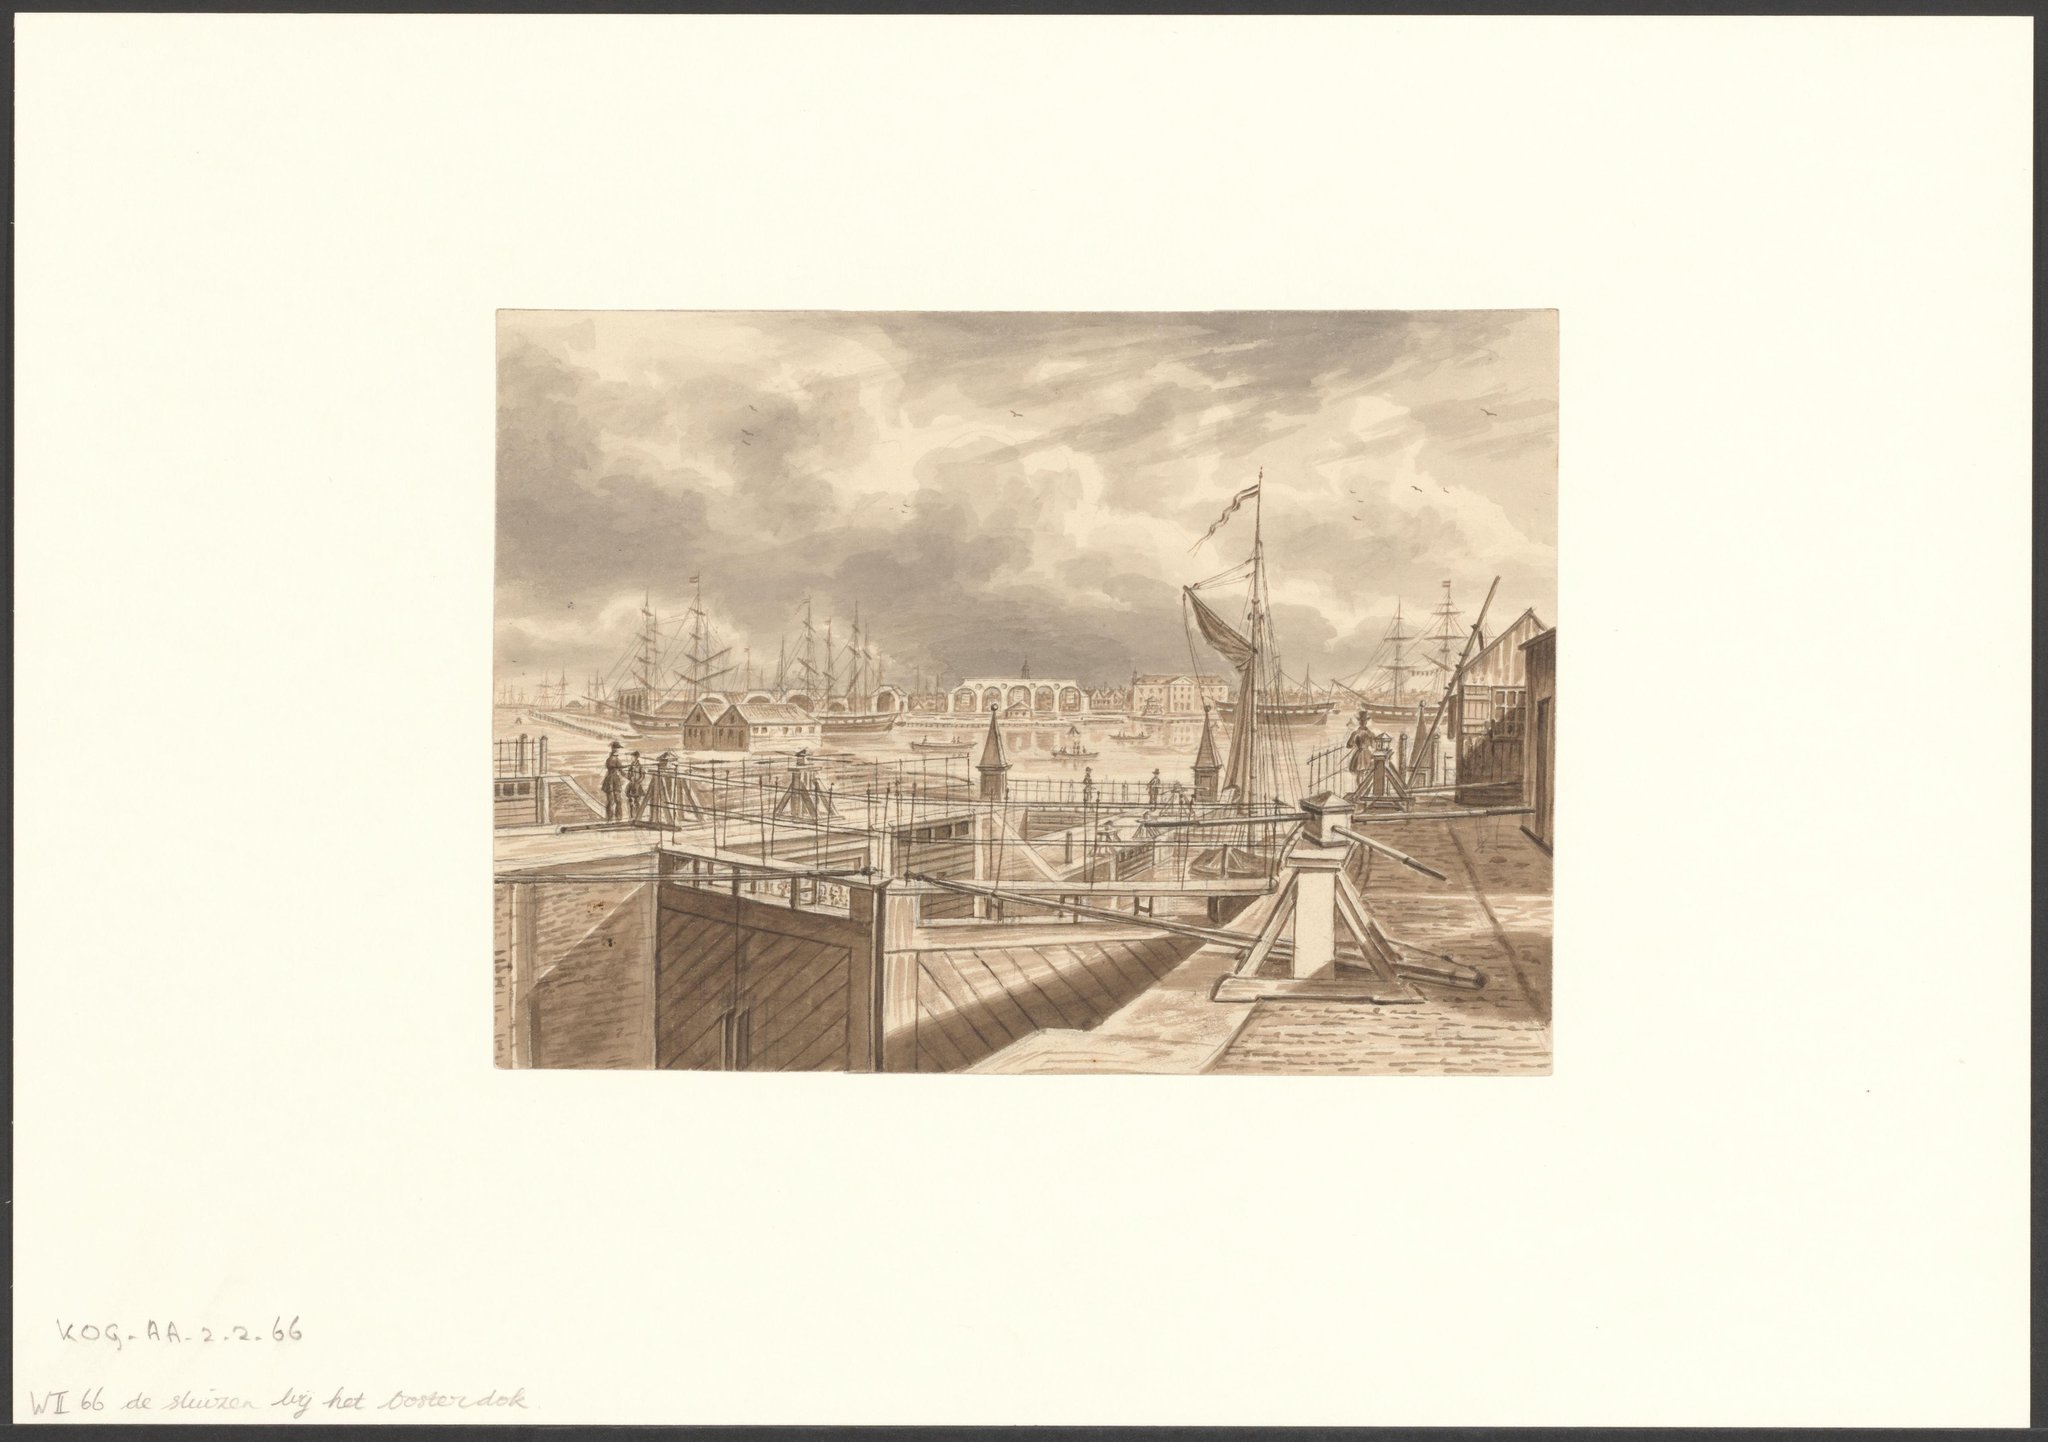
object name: drawing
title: Gezicht op de sluizen bij het Oosterdok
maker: augustus wijnantz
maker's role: draughtsman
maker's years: 1795-1848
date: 1744-1807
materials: ink, paper, pencil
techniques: brush, pen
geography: amsterdam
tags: sluice, weir, city-view in general; 'veduta', river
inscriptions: collector's mark: Lugt 800a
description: Tekening binnen de Atlas Van Eck ingedeeld op wijknummer 2.